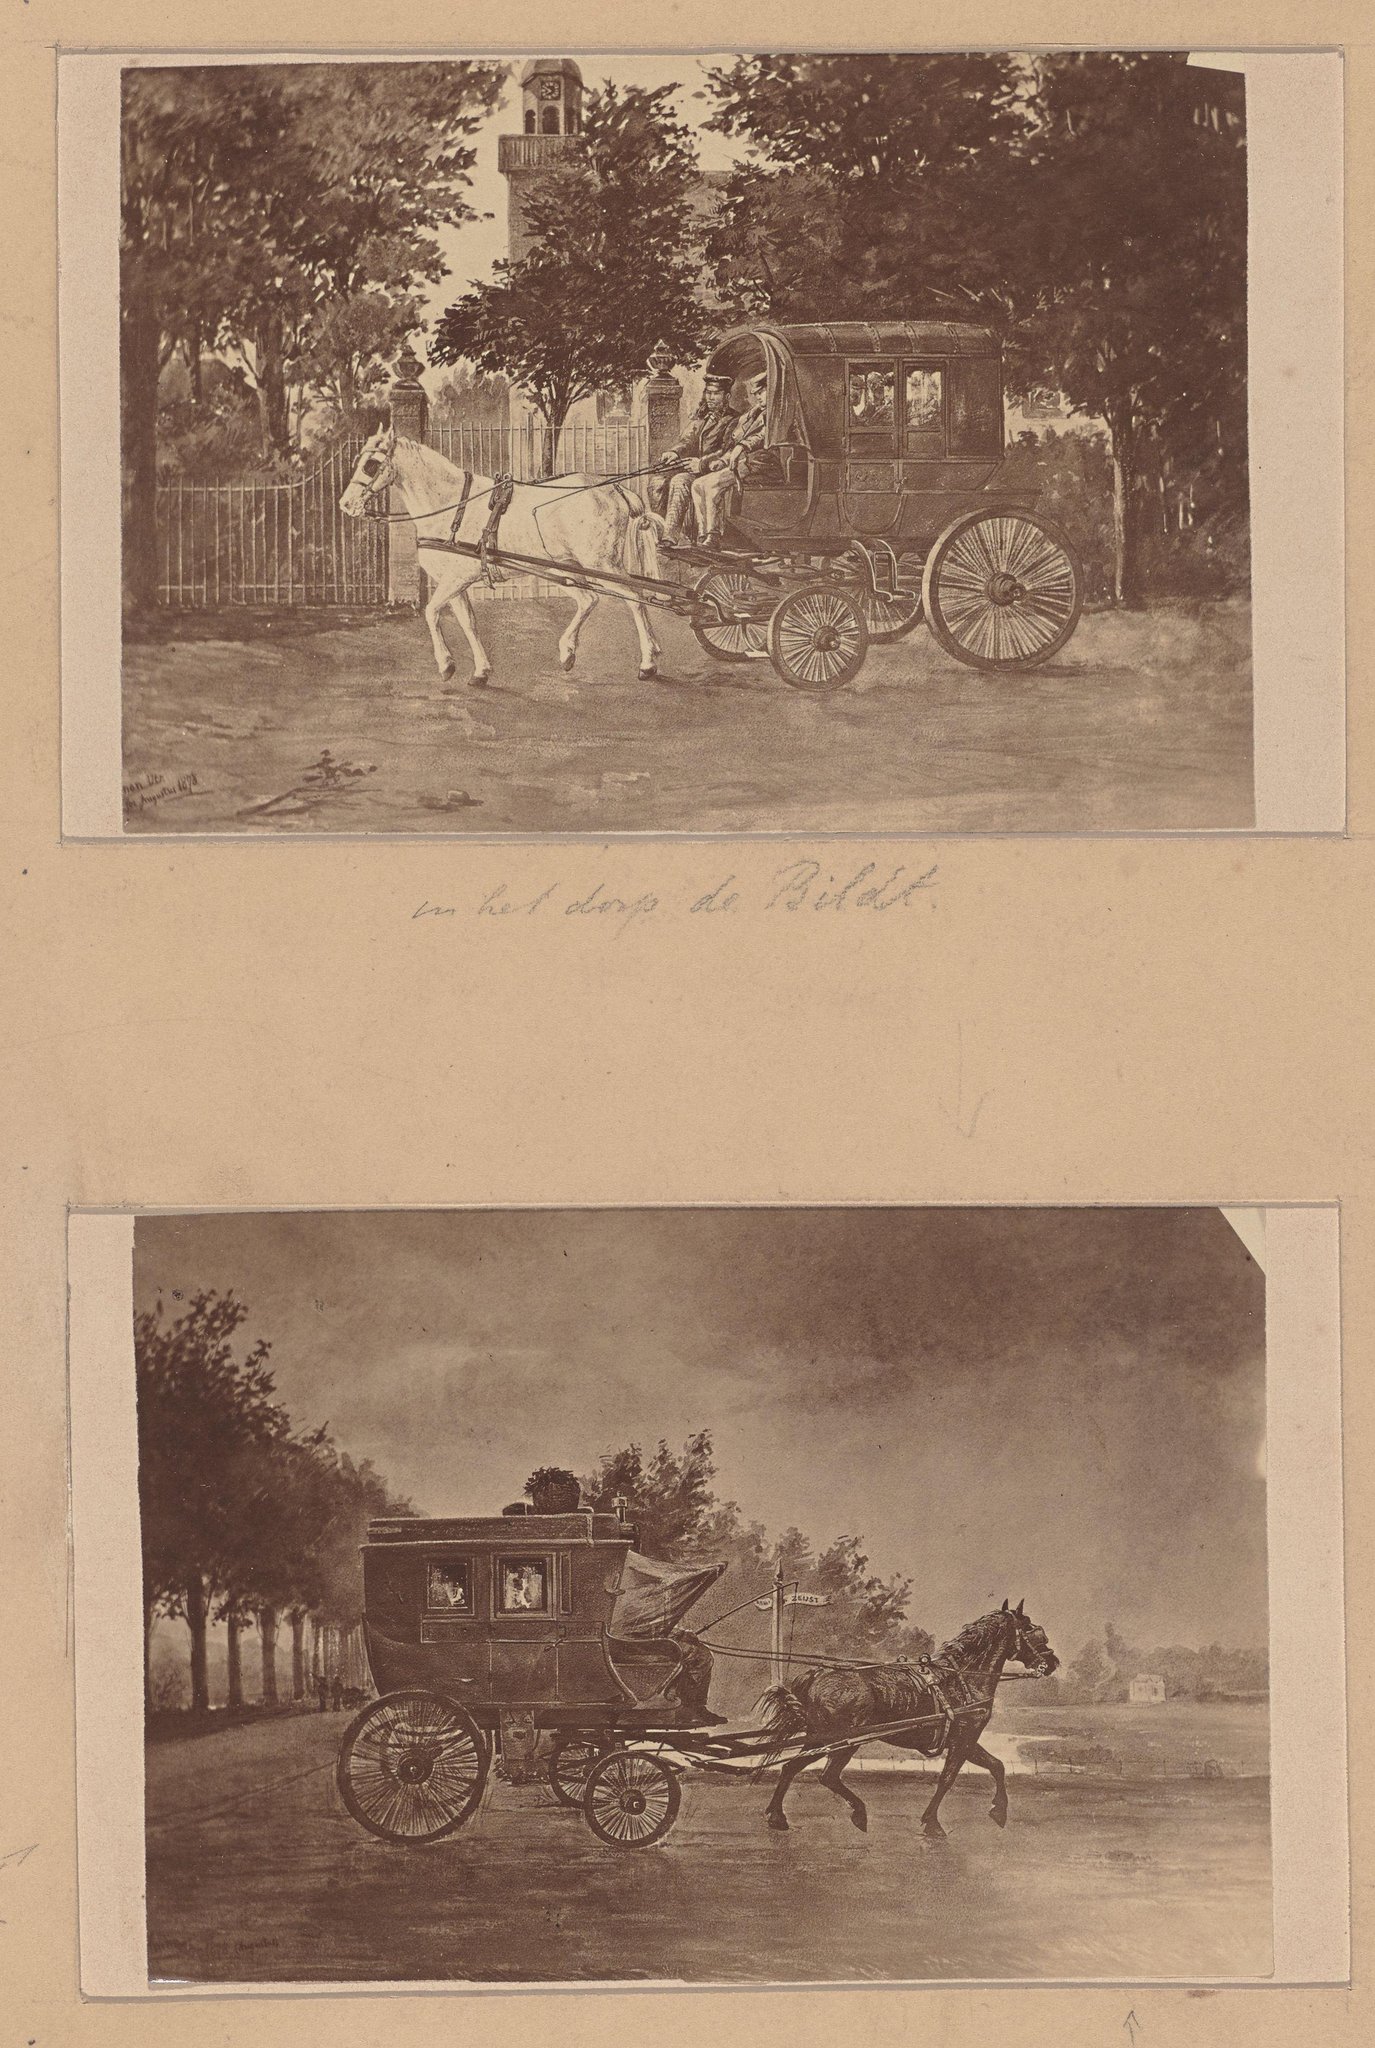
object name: photograph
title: Fotoreproductie van het Wagentje van Dieges, de koets tussen Utrecht en Zeist, 1879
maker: Anonymous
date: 1879-1926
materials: cardboard, paper, photographic support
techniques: albumen print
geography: netherlands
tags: four-wheeled vehicle drawn by one animal, drawing, sketch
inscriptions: collector's mark: Lugt 2228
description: Fotoreproductie van een tekening van Grolman uit september 1879 van het 'Wagentje van Dieges', de koets die tussen Utrecht en Zeist reed tot juli 1879 toen het vervangen werd door een tram. Het rijtuig getrokken door een donker paard bij de Amersfoortsestraatweg richting Zeist. Samen met de pendant op één blad opzet.